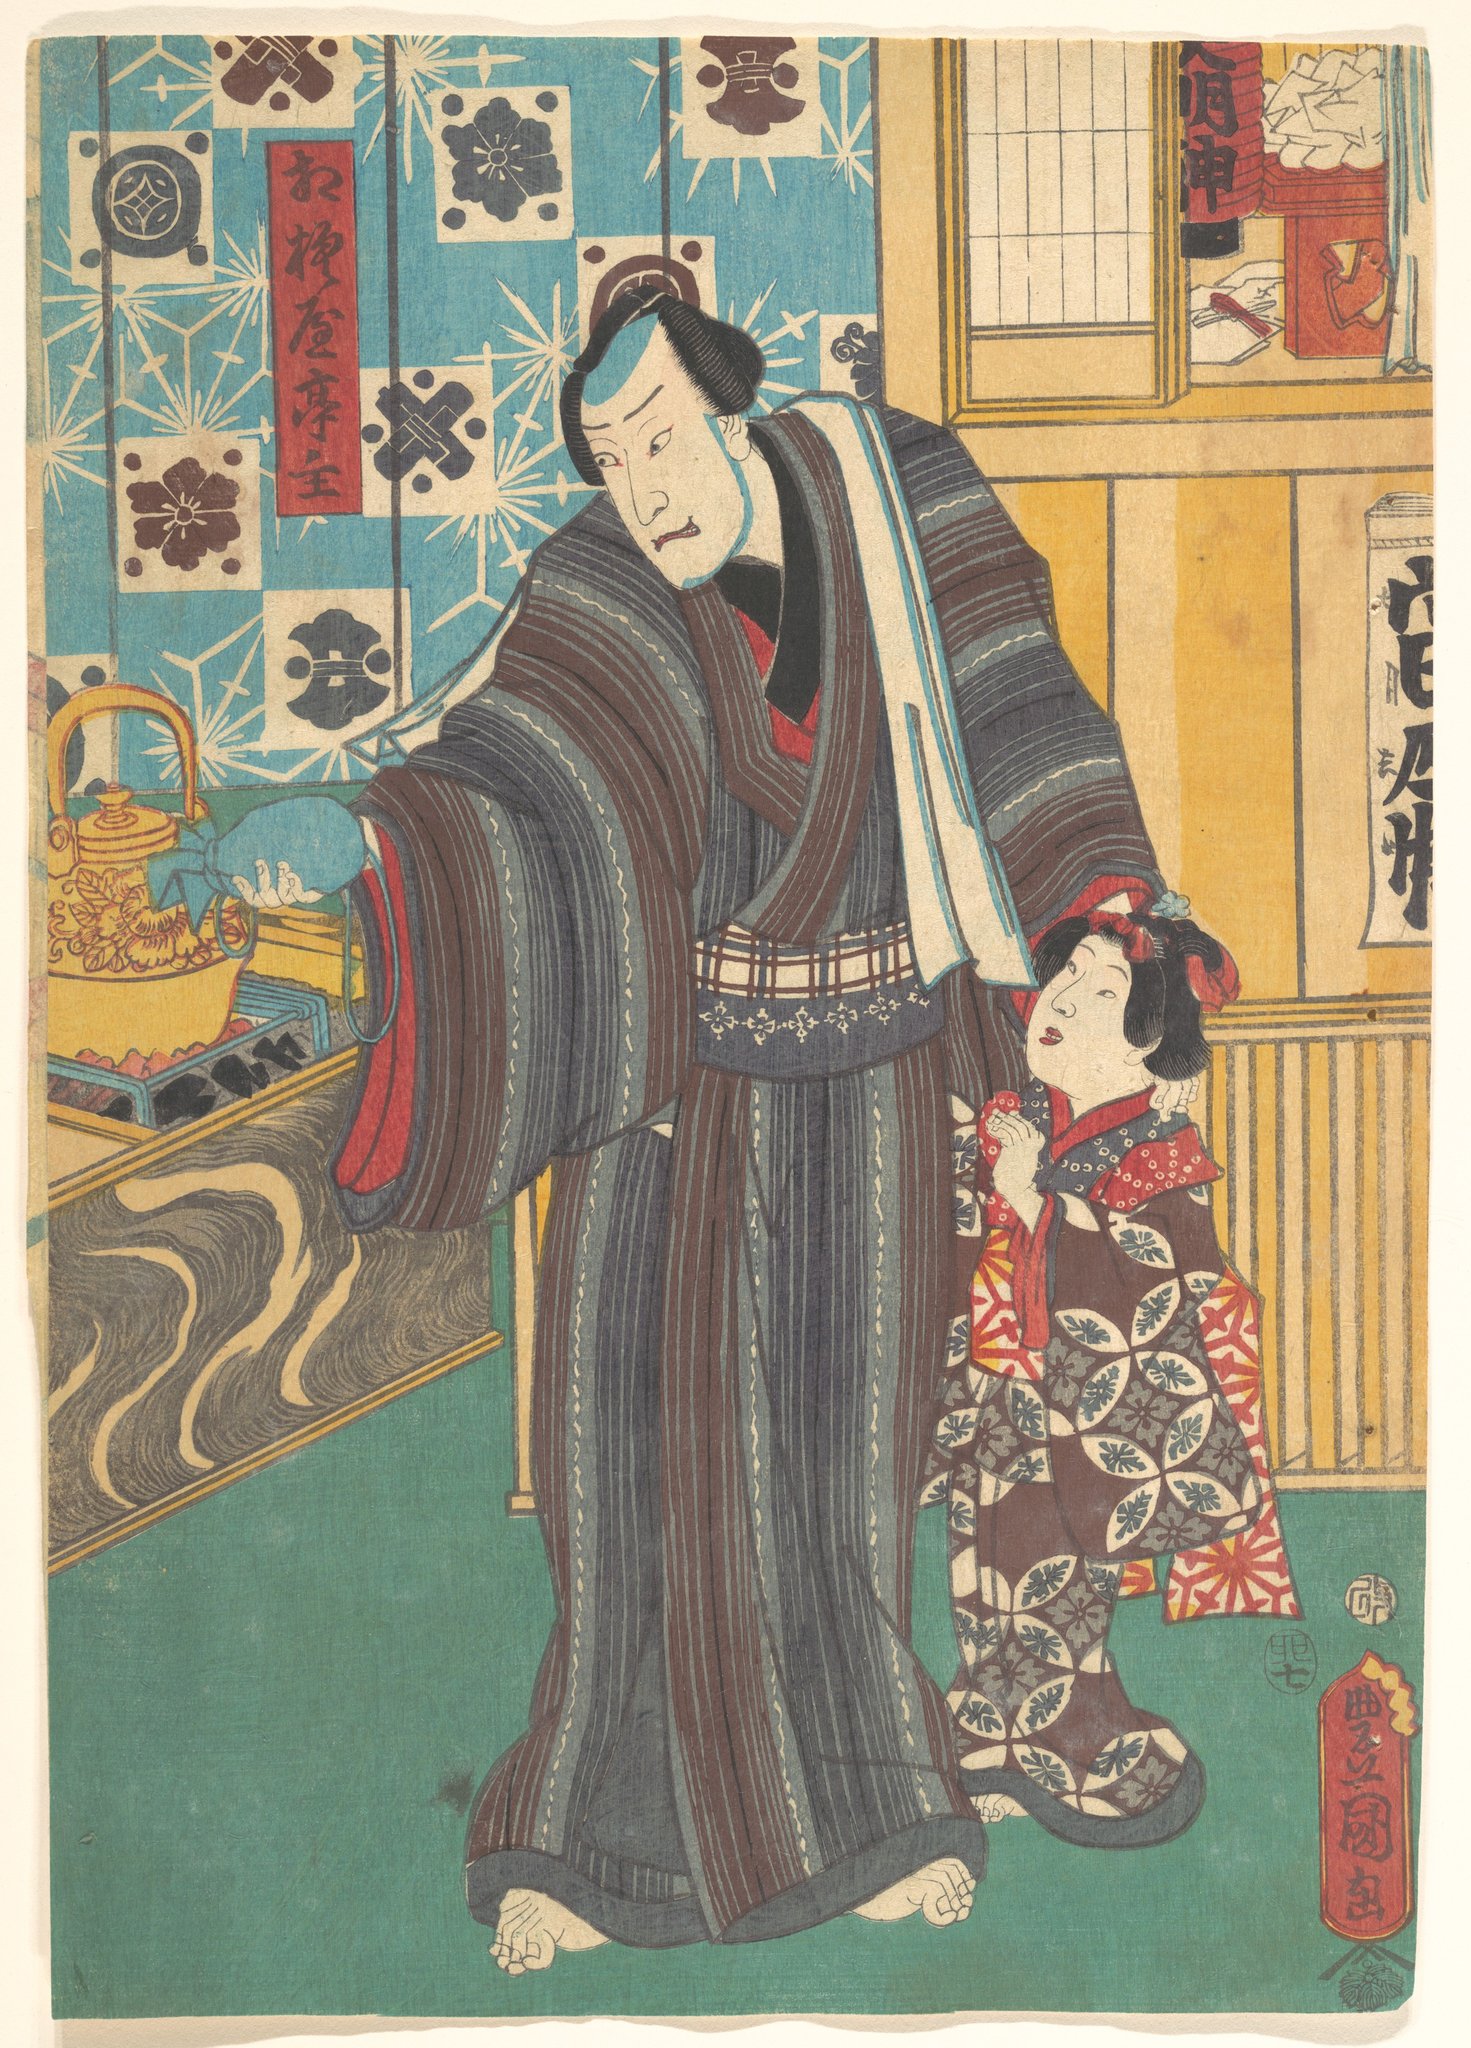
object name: print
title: Actor as Master of Sagamiya (Sagamiya teishu)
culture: japanese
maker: utagawa kunisada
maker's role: artist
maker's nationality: japanese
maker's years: 1786-1864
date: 1801-1900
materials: ink, panel, paper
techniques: woodblock print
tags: girls,men,actors